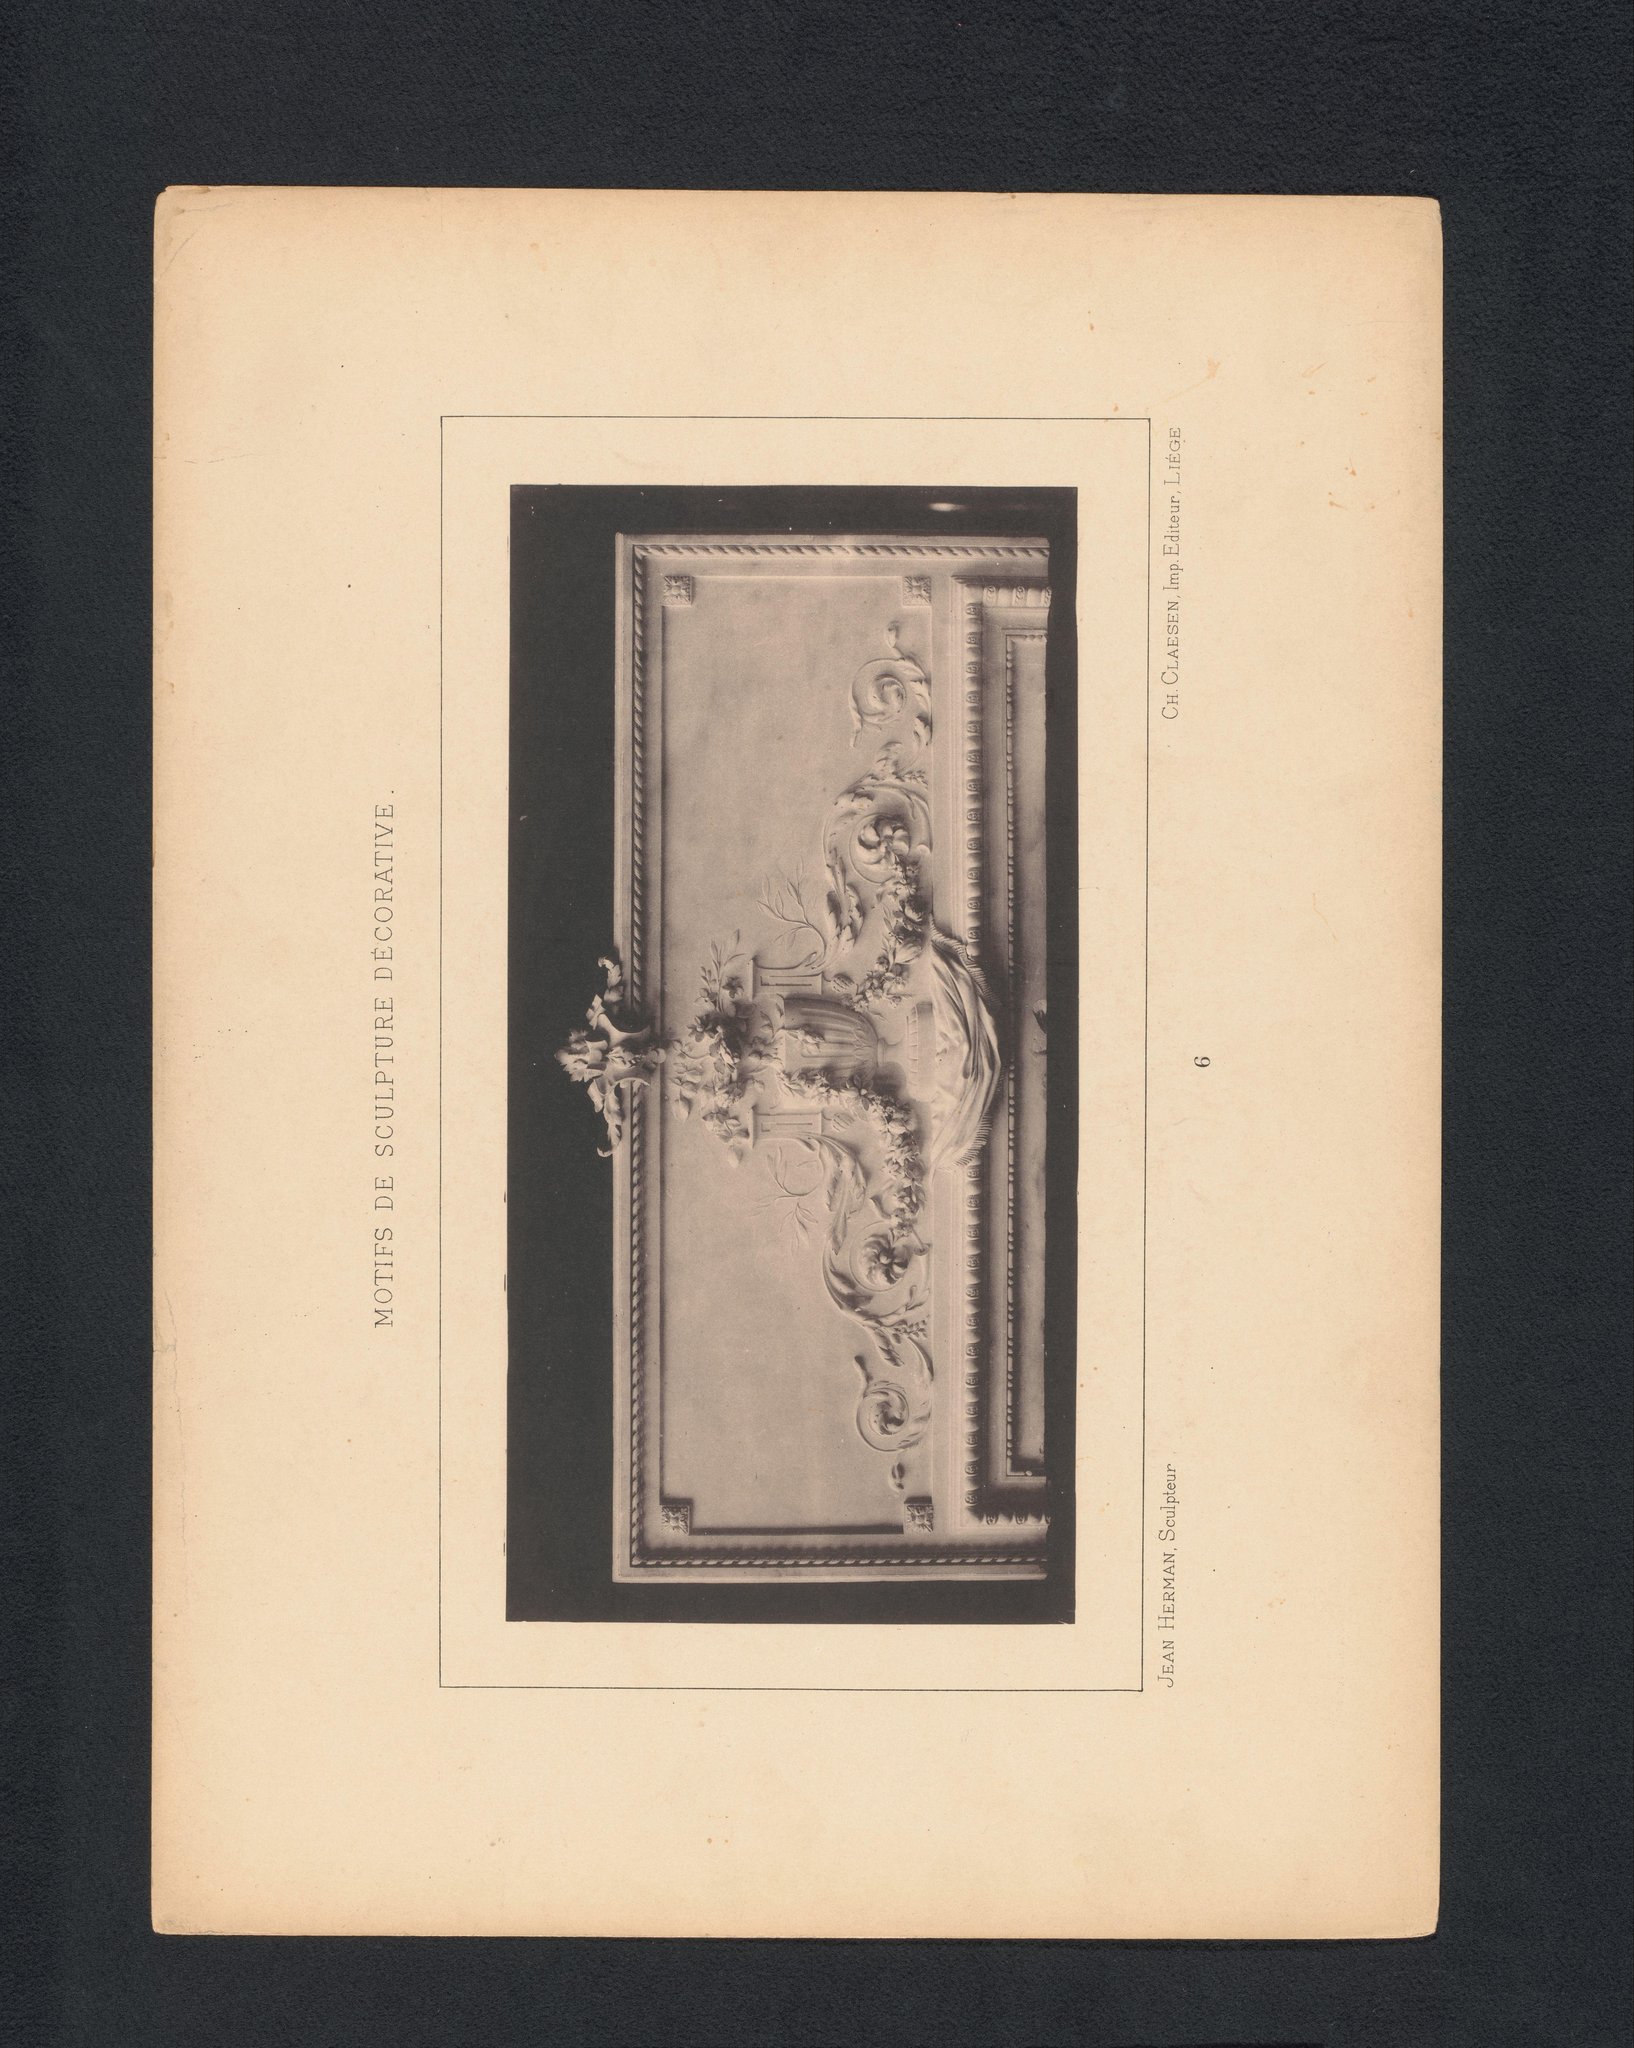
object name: photomechanical print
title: Reliëf van een kelk met bloemen en bladranken, gebeeldhouwd door Jean Herman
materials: paper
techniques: photograph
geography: liège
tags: chalice, ornament derived from plant forms, sculpture (+ relief ~ sculpture)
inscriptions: inscription: ‘Jean Herman, Sculpteur.’, number: ‘6’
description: Deze prent maakt deel uit van een omslag met 28 prenten en een titelblad.